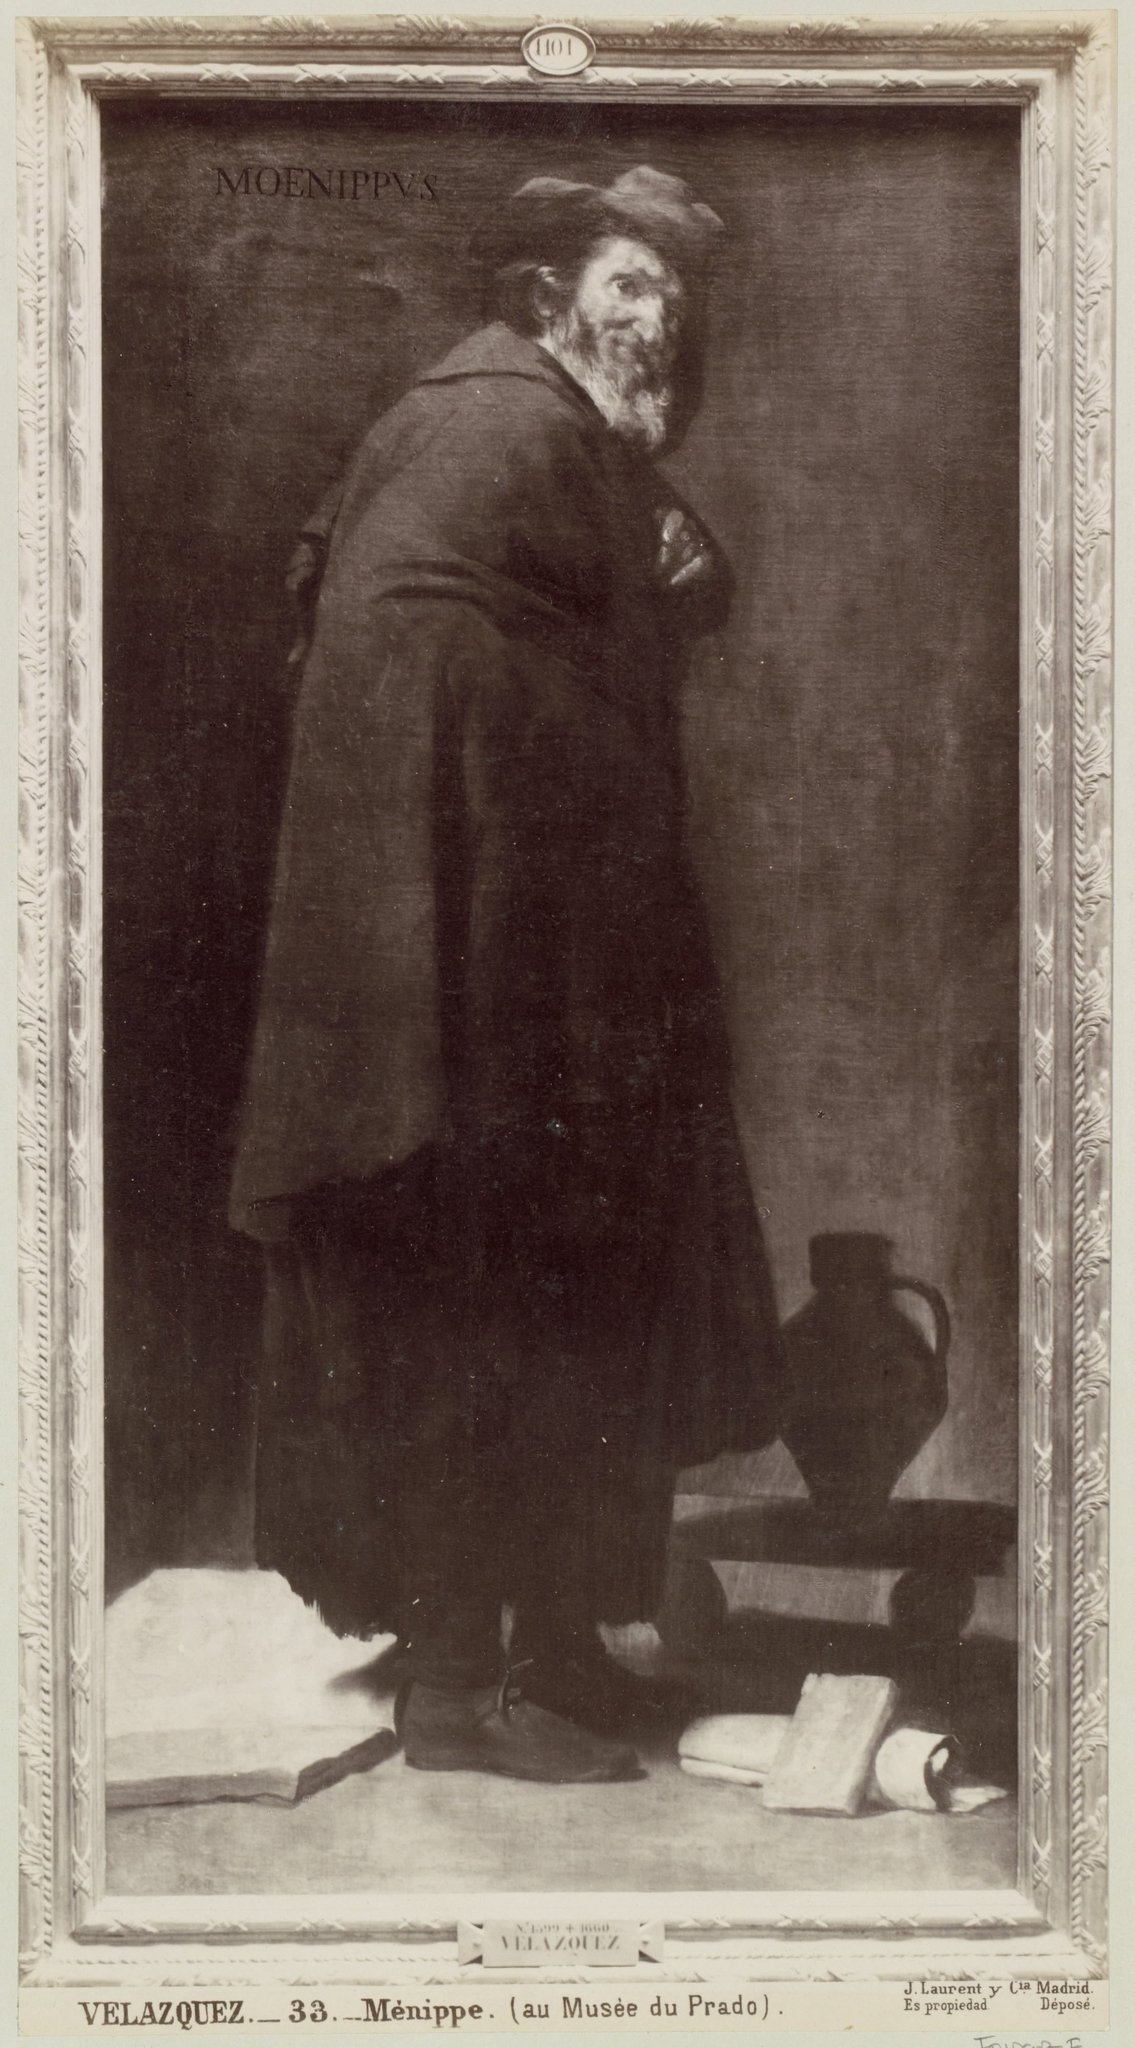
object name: photograph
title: Fotoreproductie van een schilderij door Velázquez, voorstellend een portret van de Griekse filosoof Menippos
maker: juan laurent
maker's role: publisher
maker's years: 1816-1896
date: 1857-1880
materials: cardboard, paper, photographic support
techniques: albumen print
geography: madrid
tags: scholar, philosopher, adult man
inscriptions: negative number: ‘33’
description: Onderdeel van Reisalbum met foto's van bezienswaardigheden in Spanje en Marokko.